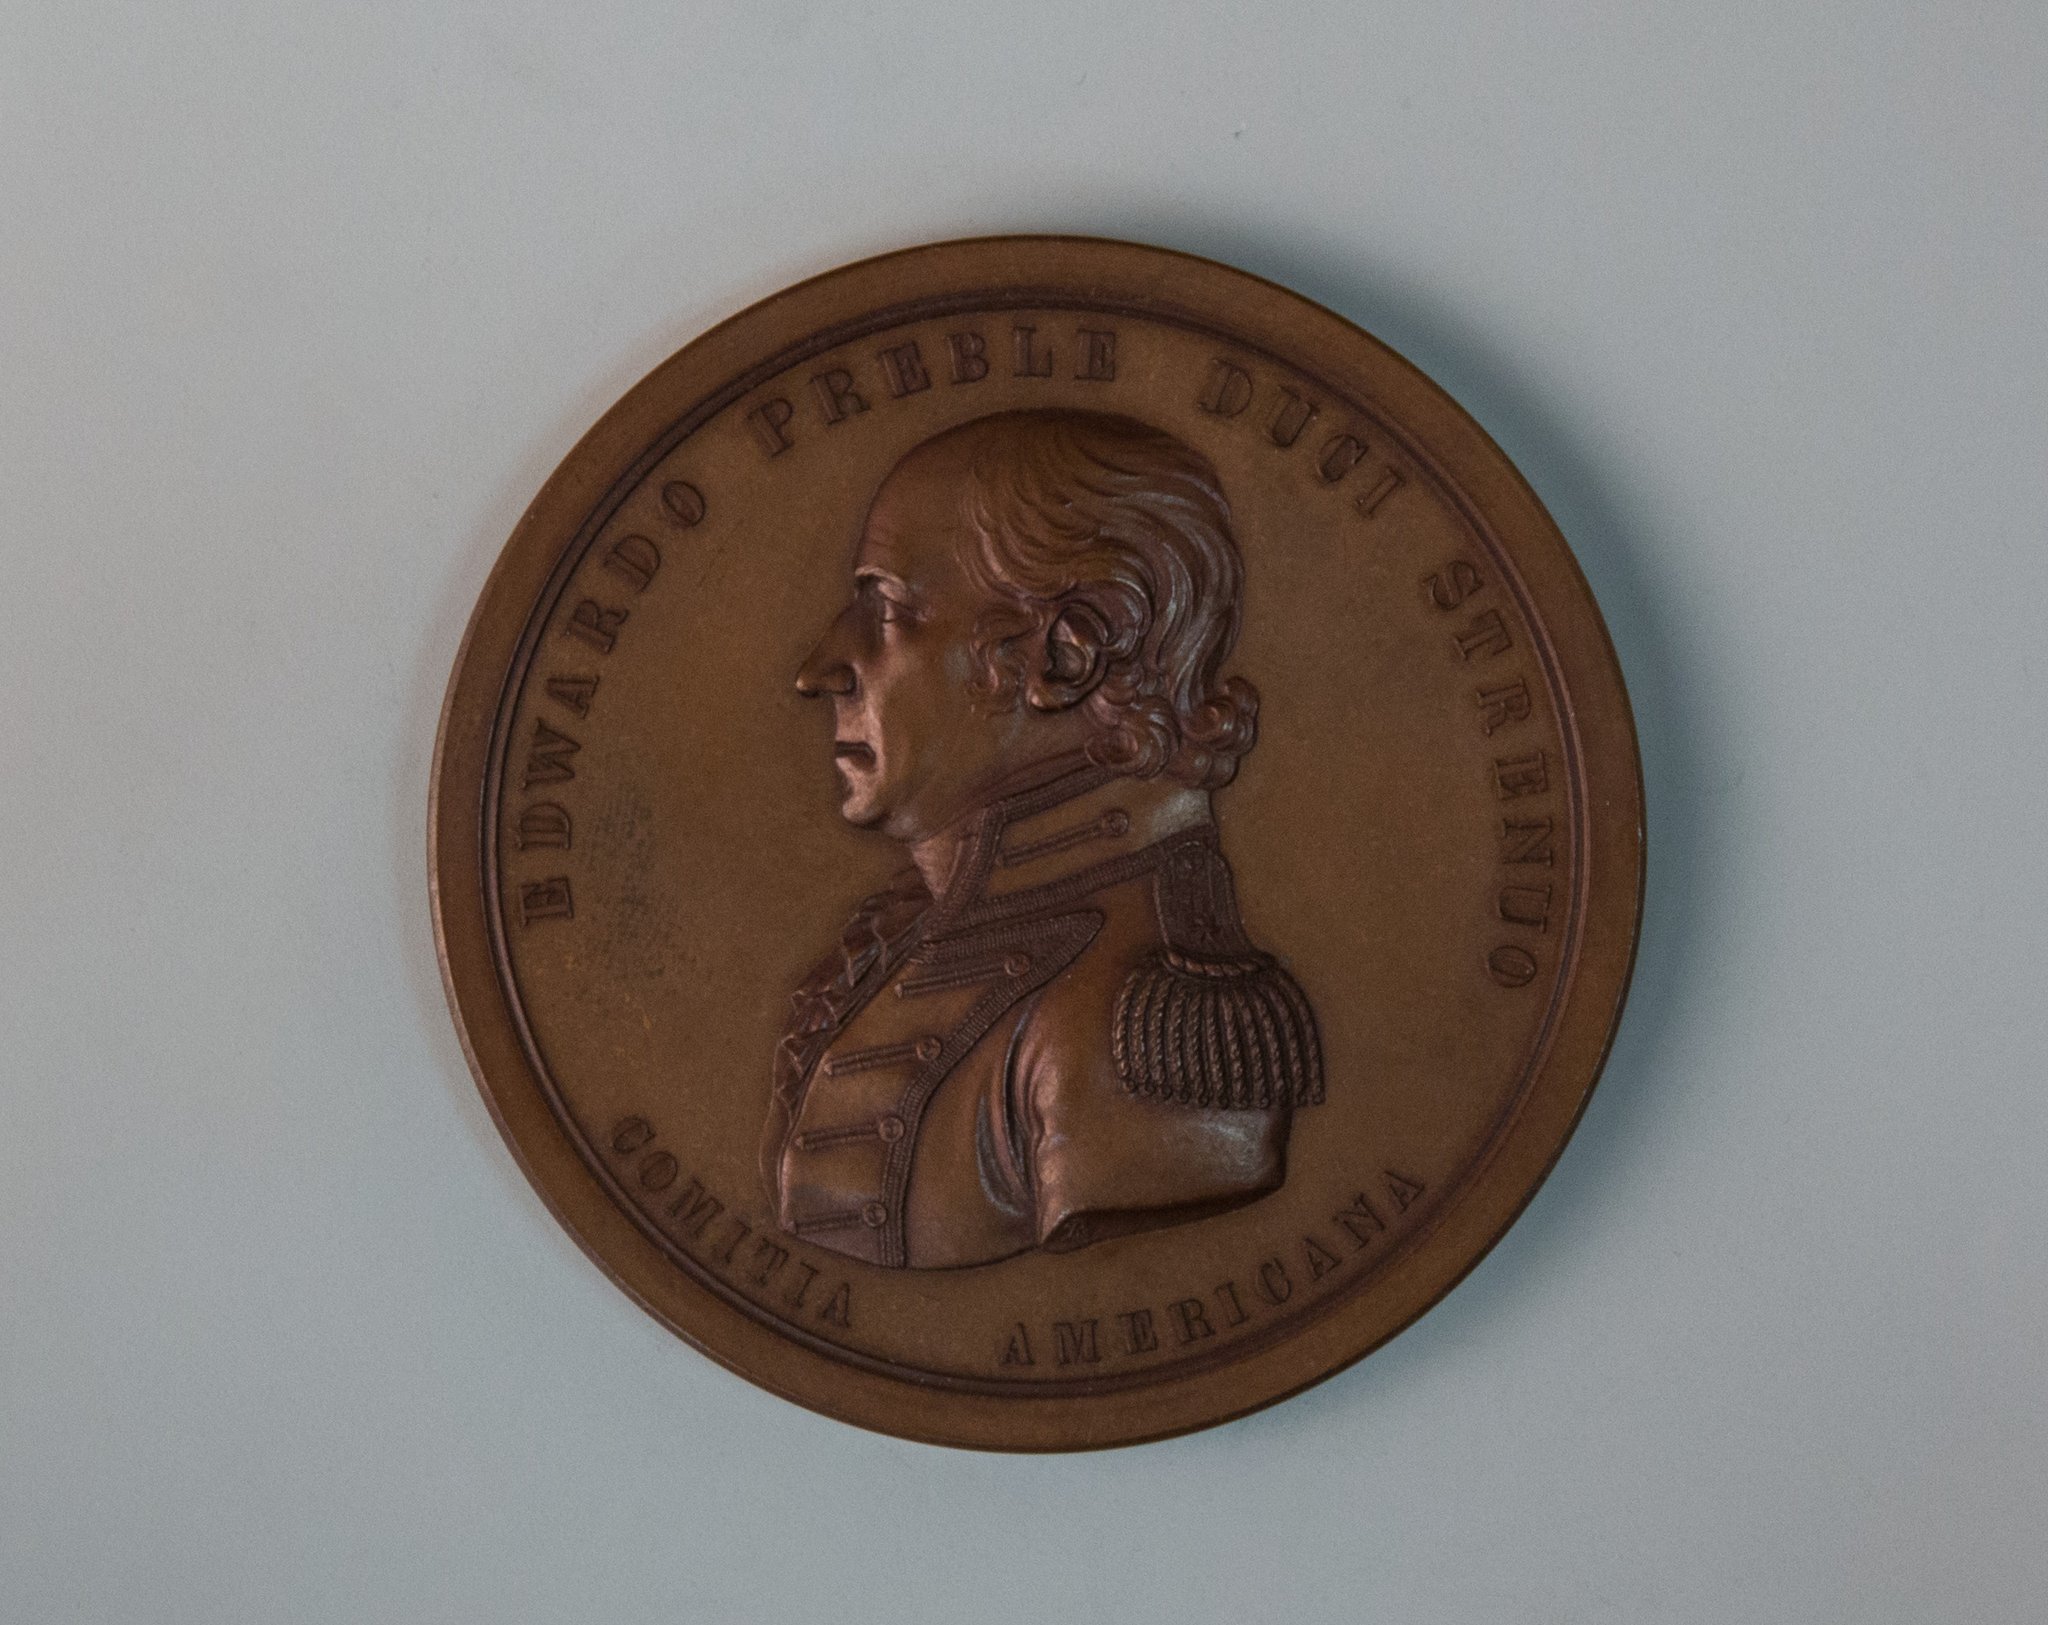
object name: medal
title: Commodore Edward Preble (1761–1807) and his Bombardment of Tripoli, August 3, 1804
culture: american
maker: johann mathias reich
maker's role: artist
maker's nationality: american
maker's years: 1768-1833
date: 1804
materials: bronze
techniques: struck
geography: united states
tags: men,portraits,profiles,ships